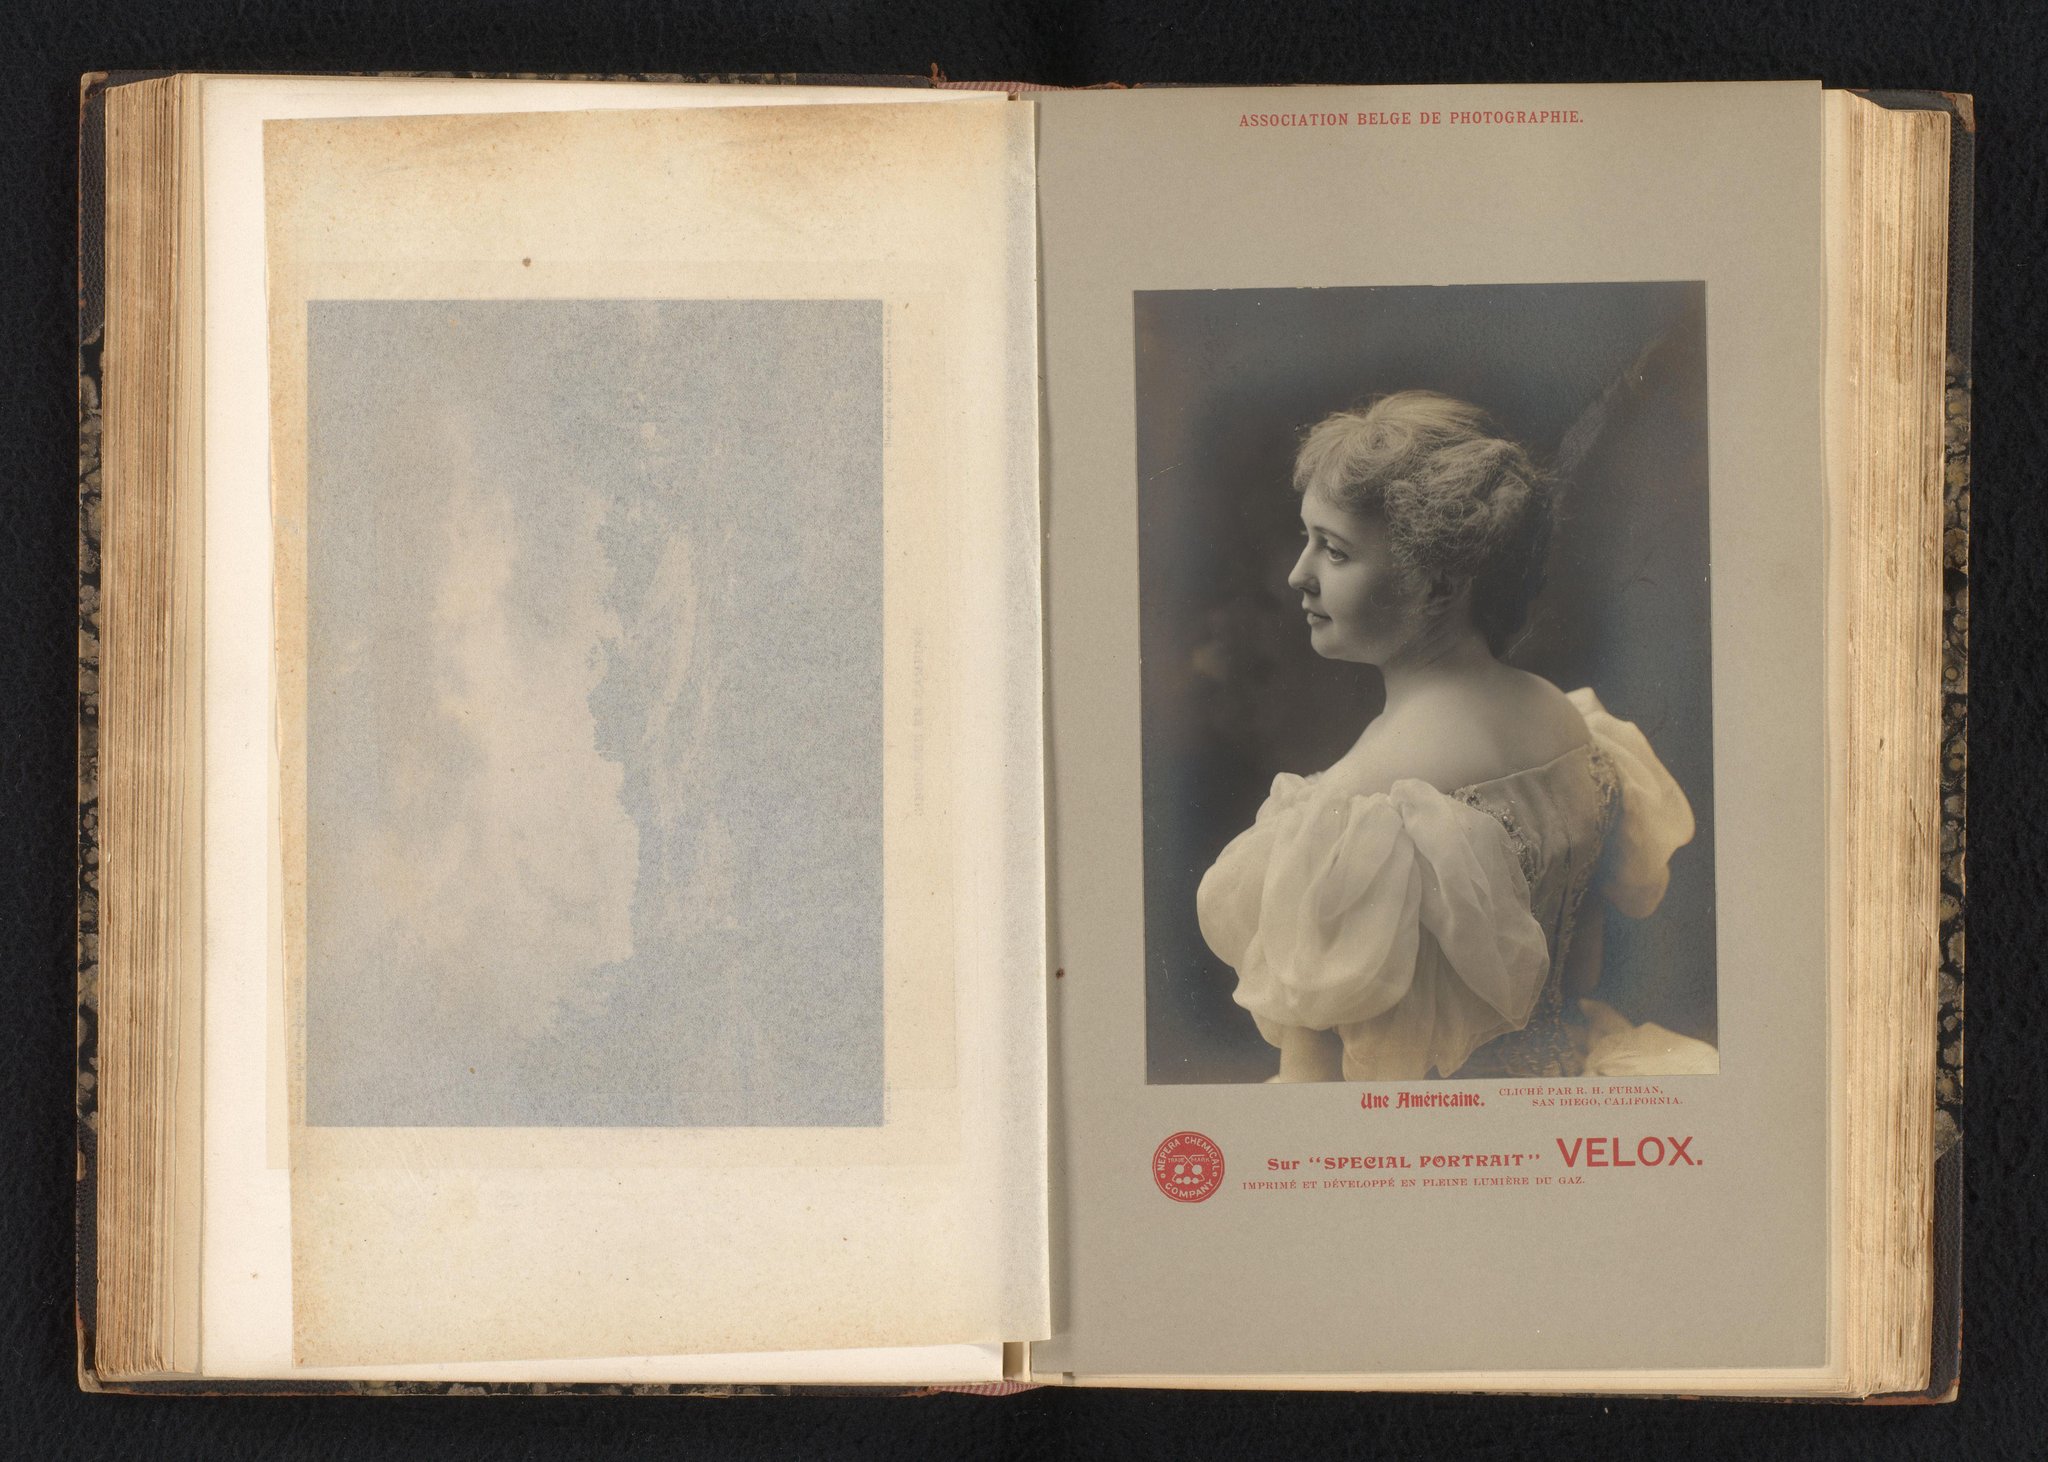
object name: page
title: Portret van een onbekende jonge vrouw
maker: robert henry furman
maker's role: fotograaf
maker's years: 1840-1905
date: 1893-1898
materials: photographic support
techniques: gelatin silver print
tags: adolescent, young woman, maiden, historical persons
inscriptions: inscription: ‘Épeuvre tirée sur papier VELOX (ruguex)’, inscription: ‘Sur "Special Portrait" Velox./ Imprimé et déveoppé en pleine lumiere du gaz.’, inscription: ‘Association belge de photographie’